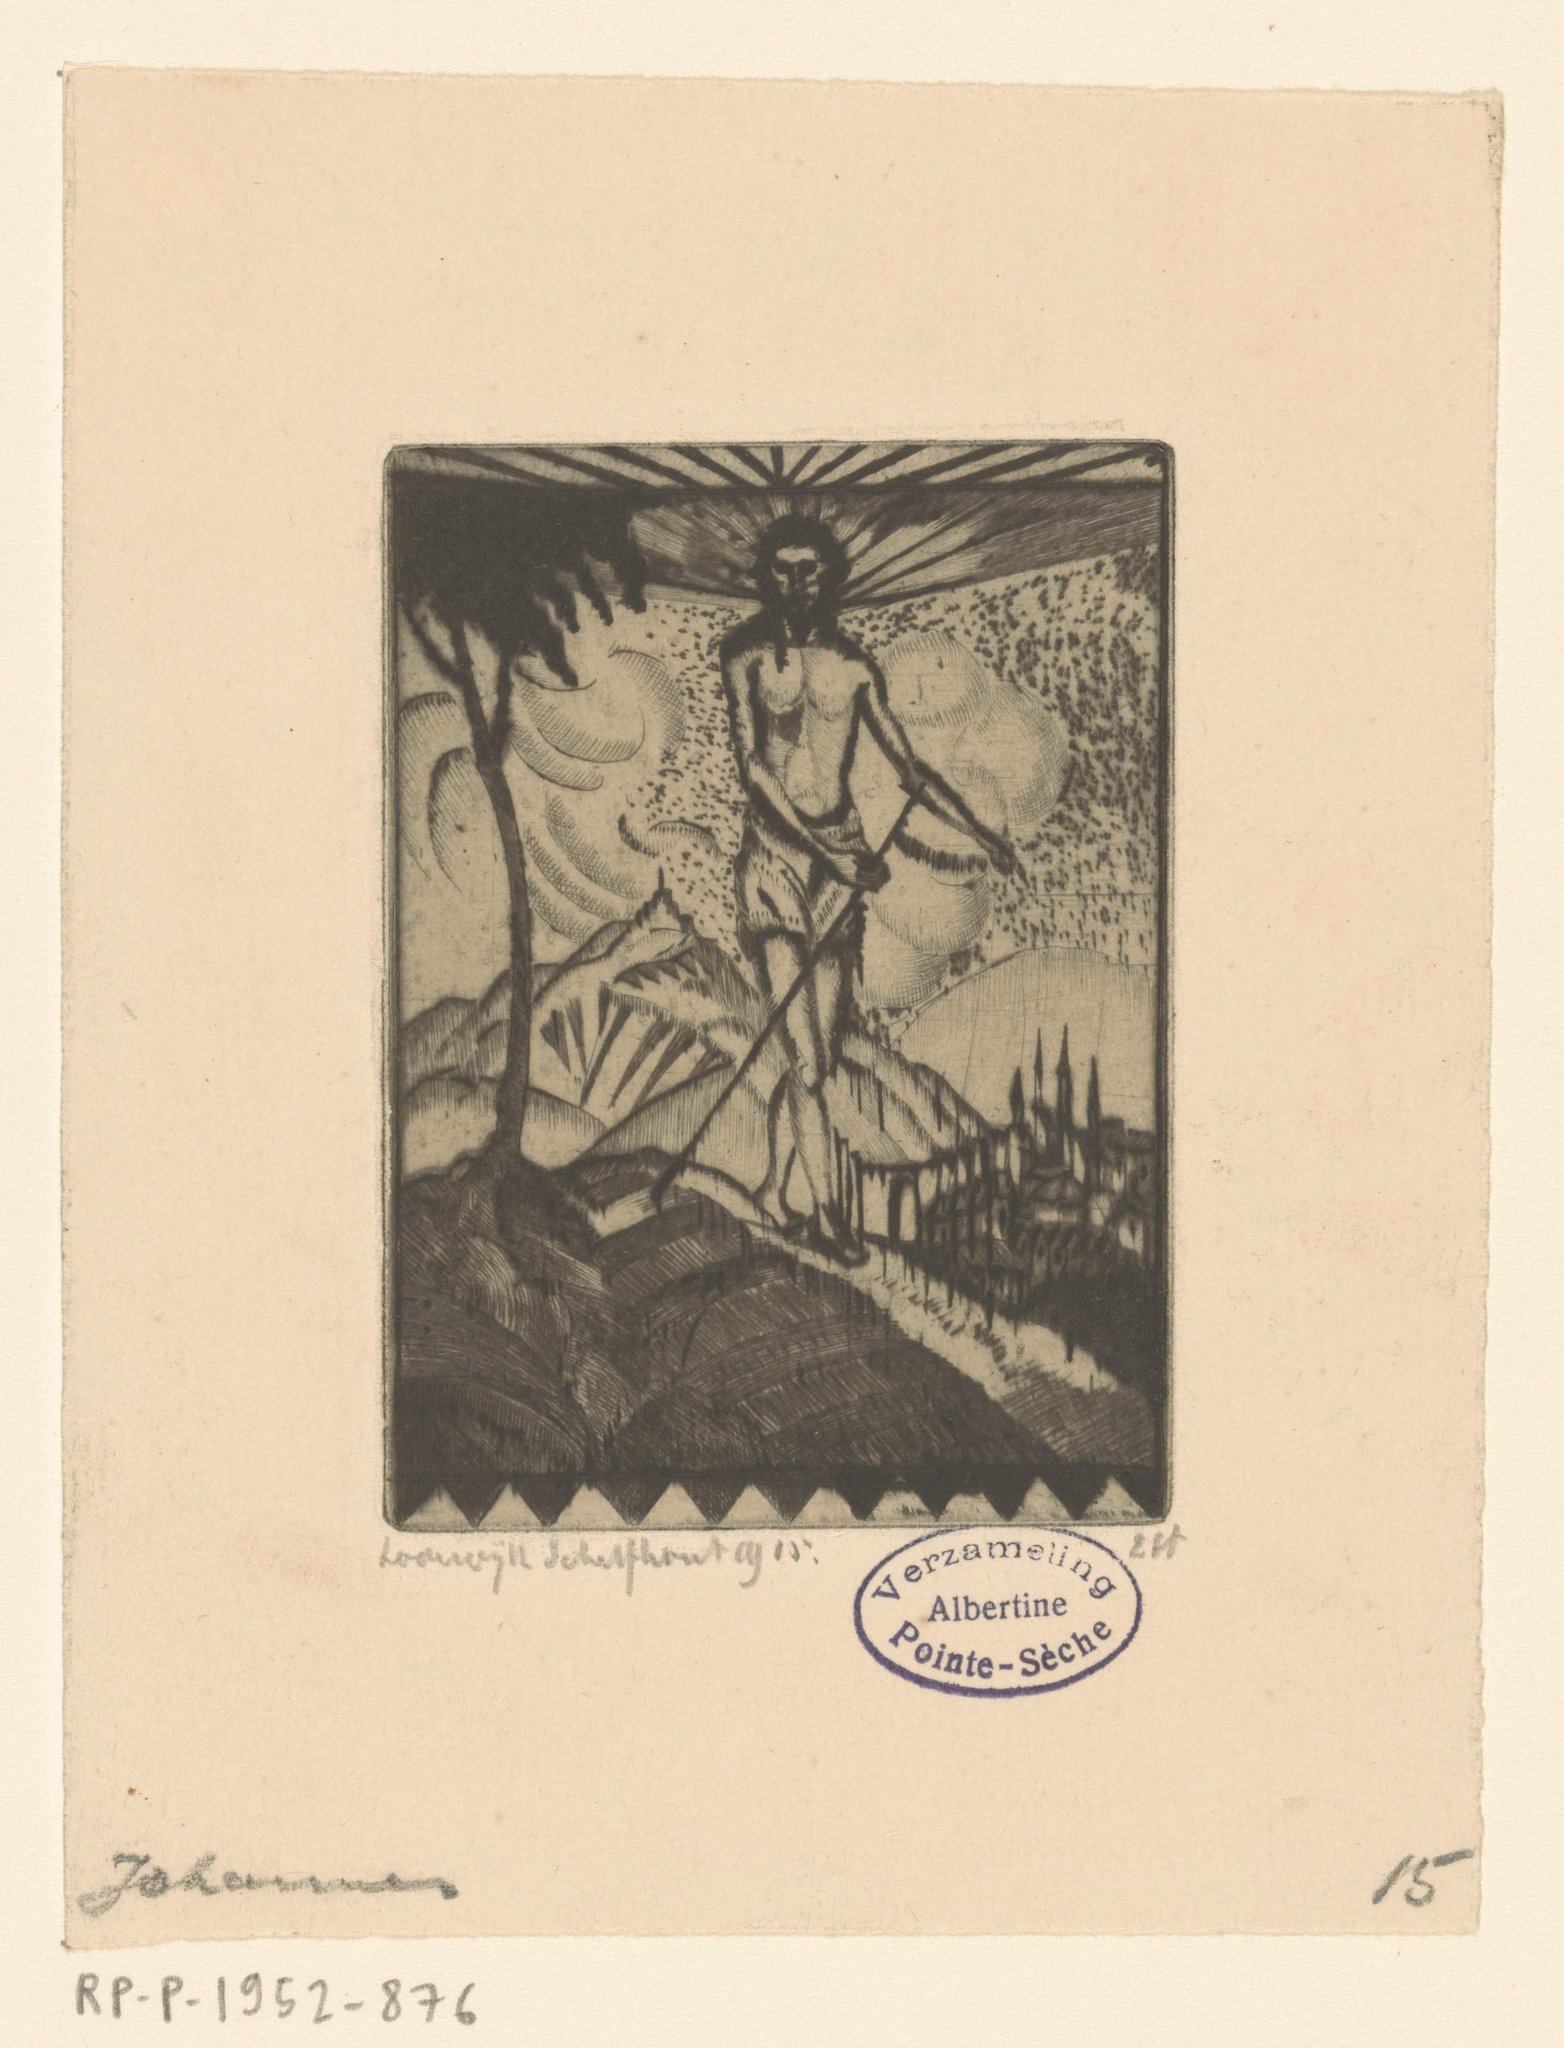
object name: print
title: Johannes de Doper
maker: lodewijk schelfhout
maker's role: draughtsman, print maker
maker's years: 1881-1943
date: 1915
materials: paper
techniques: drypoint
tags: series of scenes from the life of john the baptist, walking, mountains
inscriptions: collector's mark: Lugt 2228, collector's mark: Lugt 5i, collector's mark: Lugt 2760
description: Johannes de Doper, wandelend op een pad in een berglandschap.